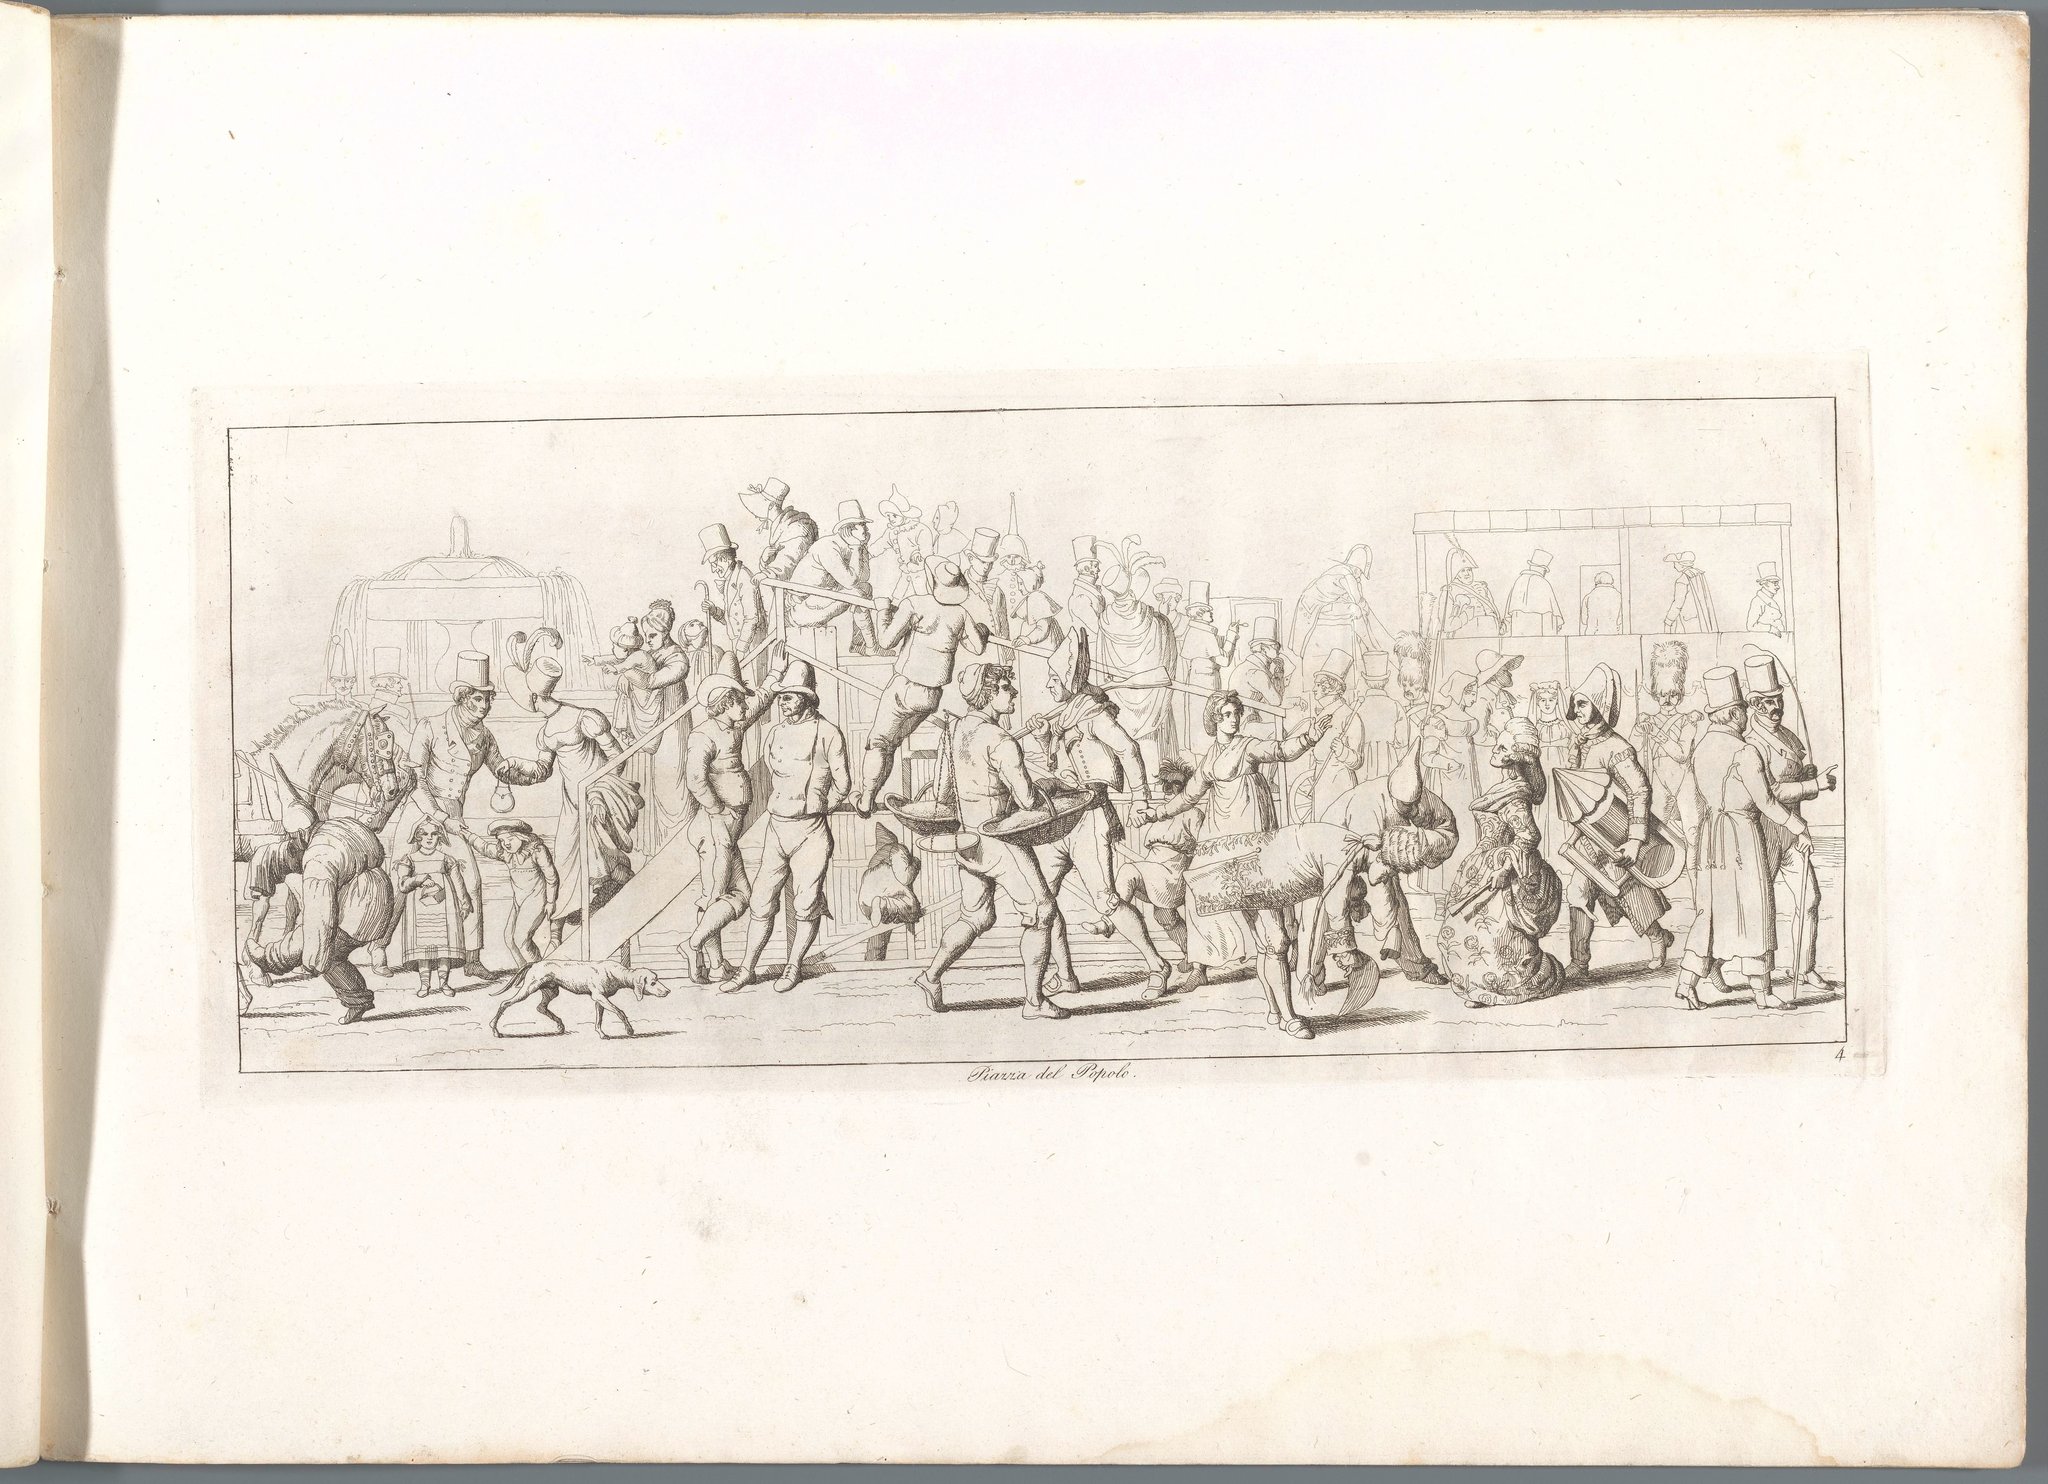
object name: print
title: Piazza del Popolo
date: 1820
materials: paper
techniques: etching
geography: rome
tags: carnival, shrovetide (non-liturgical celebration), rome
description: Feestgangers bij een stellage op de Piazza del Popolo. Onderdeel van een prentwerk met een serie van twintig prenten over de viering van carnaval in Rome.